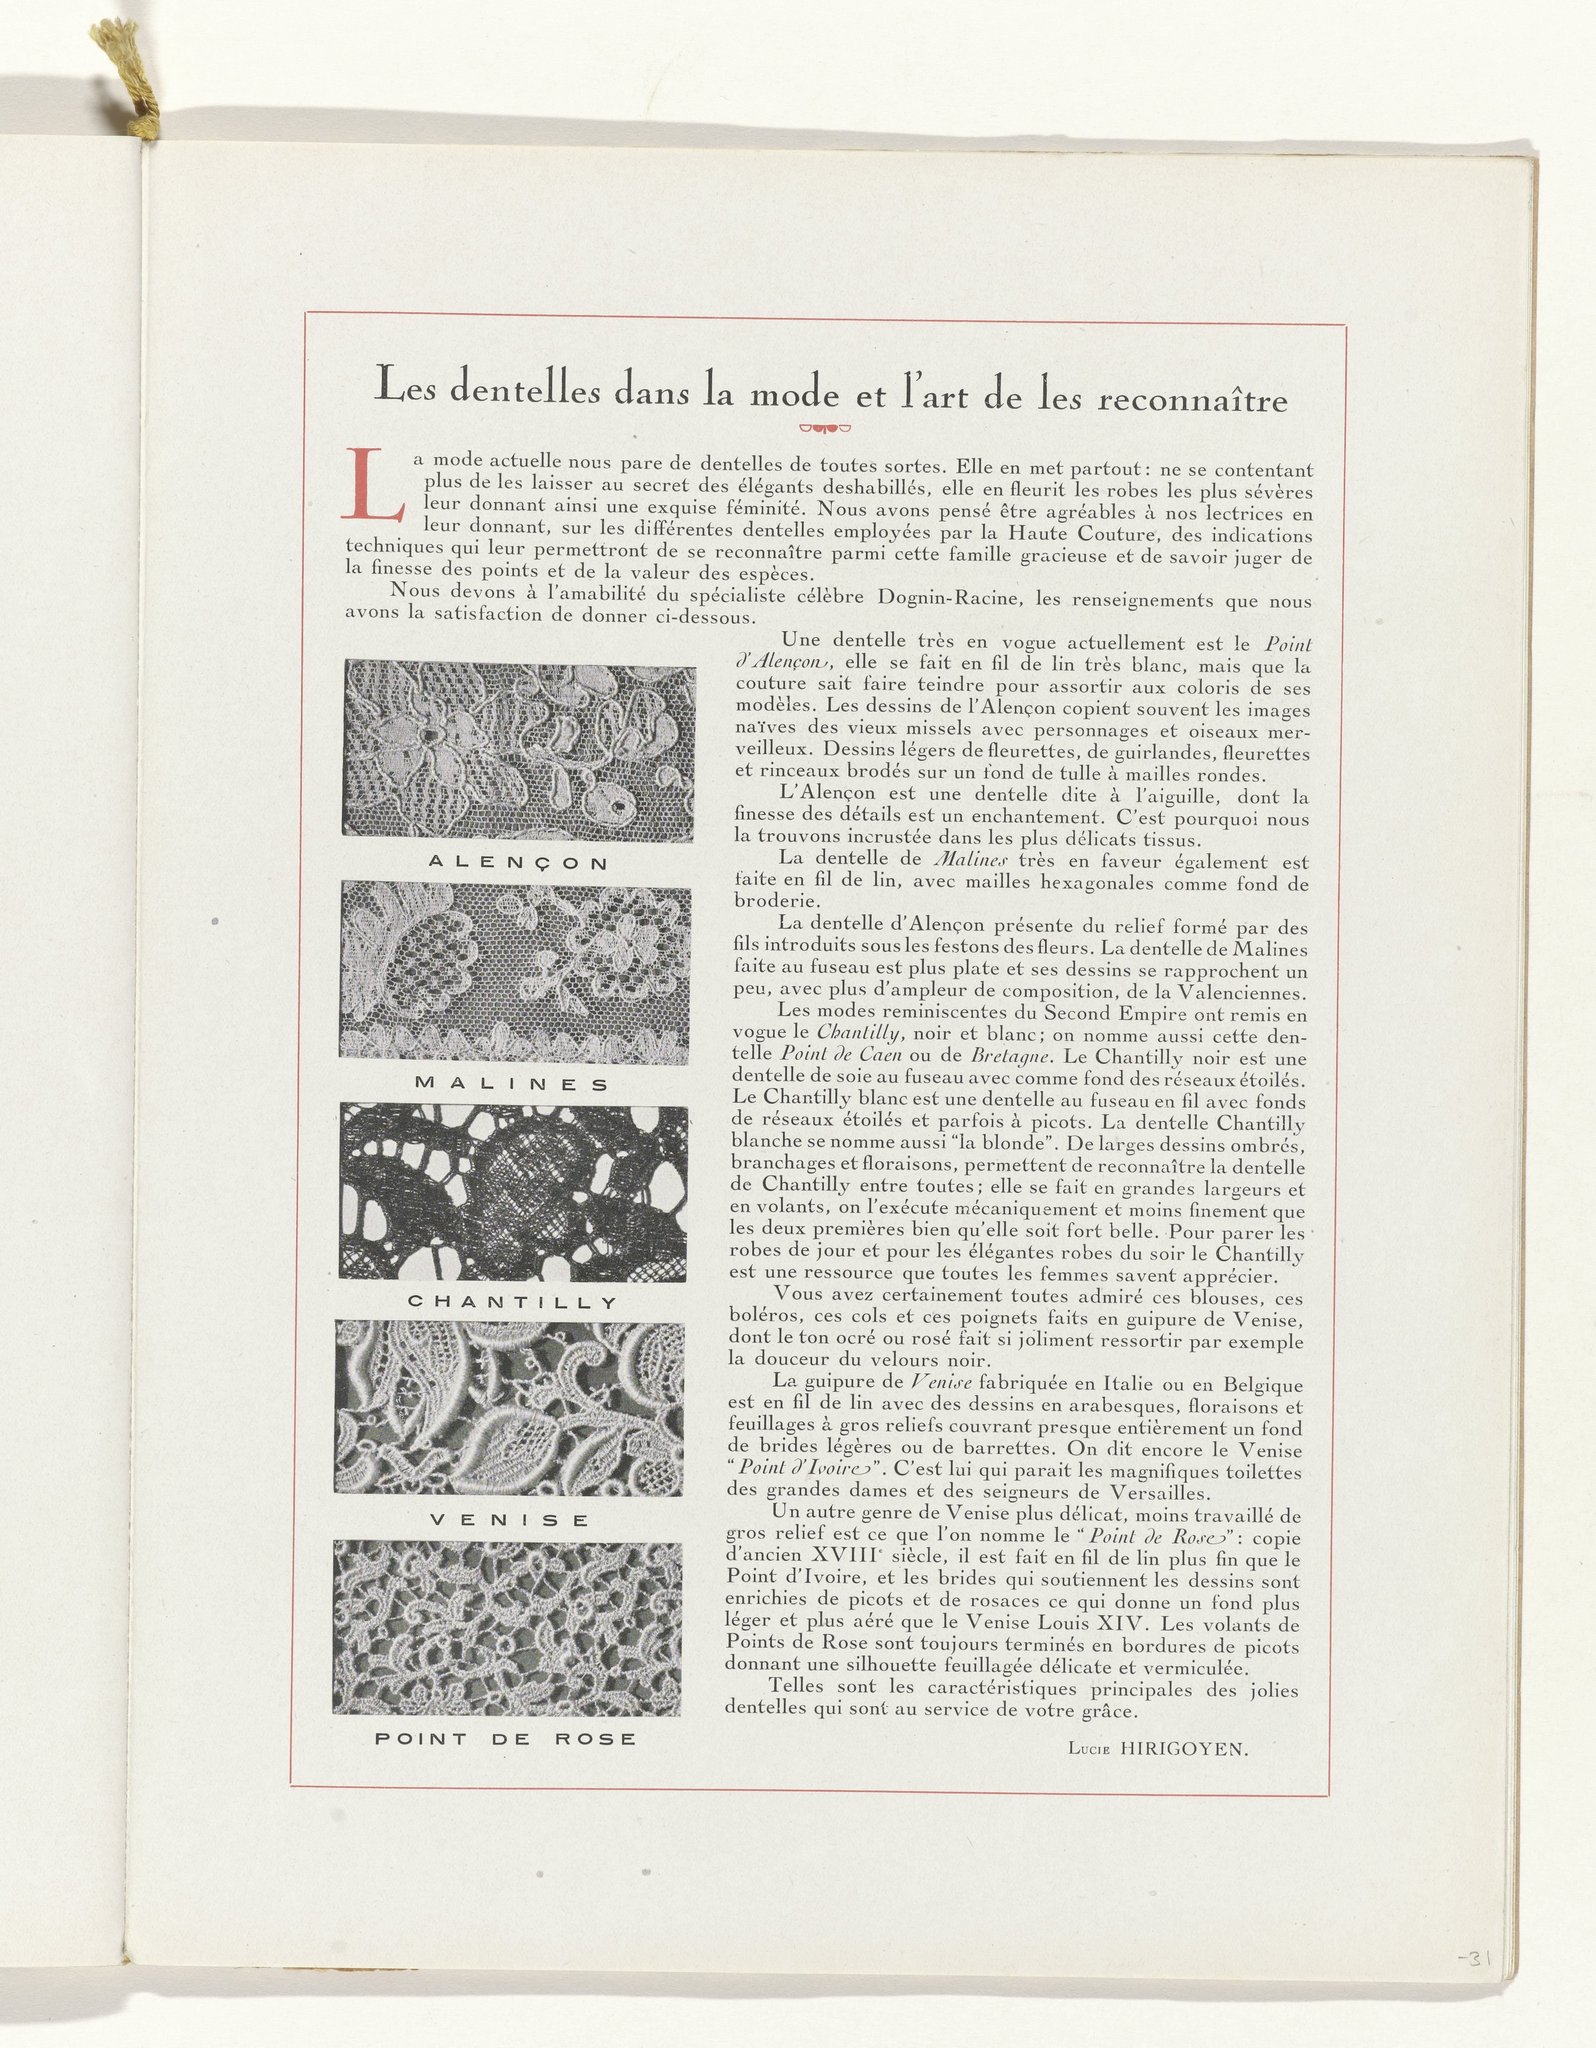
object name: magazine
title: Art - Goût - Beauté, Feuillets de l' élégance féminine, Novembre 1931, No. 135, 12e Année, p. 31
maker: charles goy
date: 1931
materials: paper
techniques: printing, photography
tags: fashion plates, lace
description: Tekst met vijf afbeeldingen van verschillende soorten kant: 'Alençon, Malines, Chantilly, Venise, Point de Rose'. Pagina uit het modetijdschrift Art-Goût-Beauté (1920-1933).